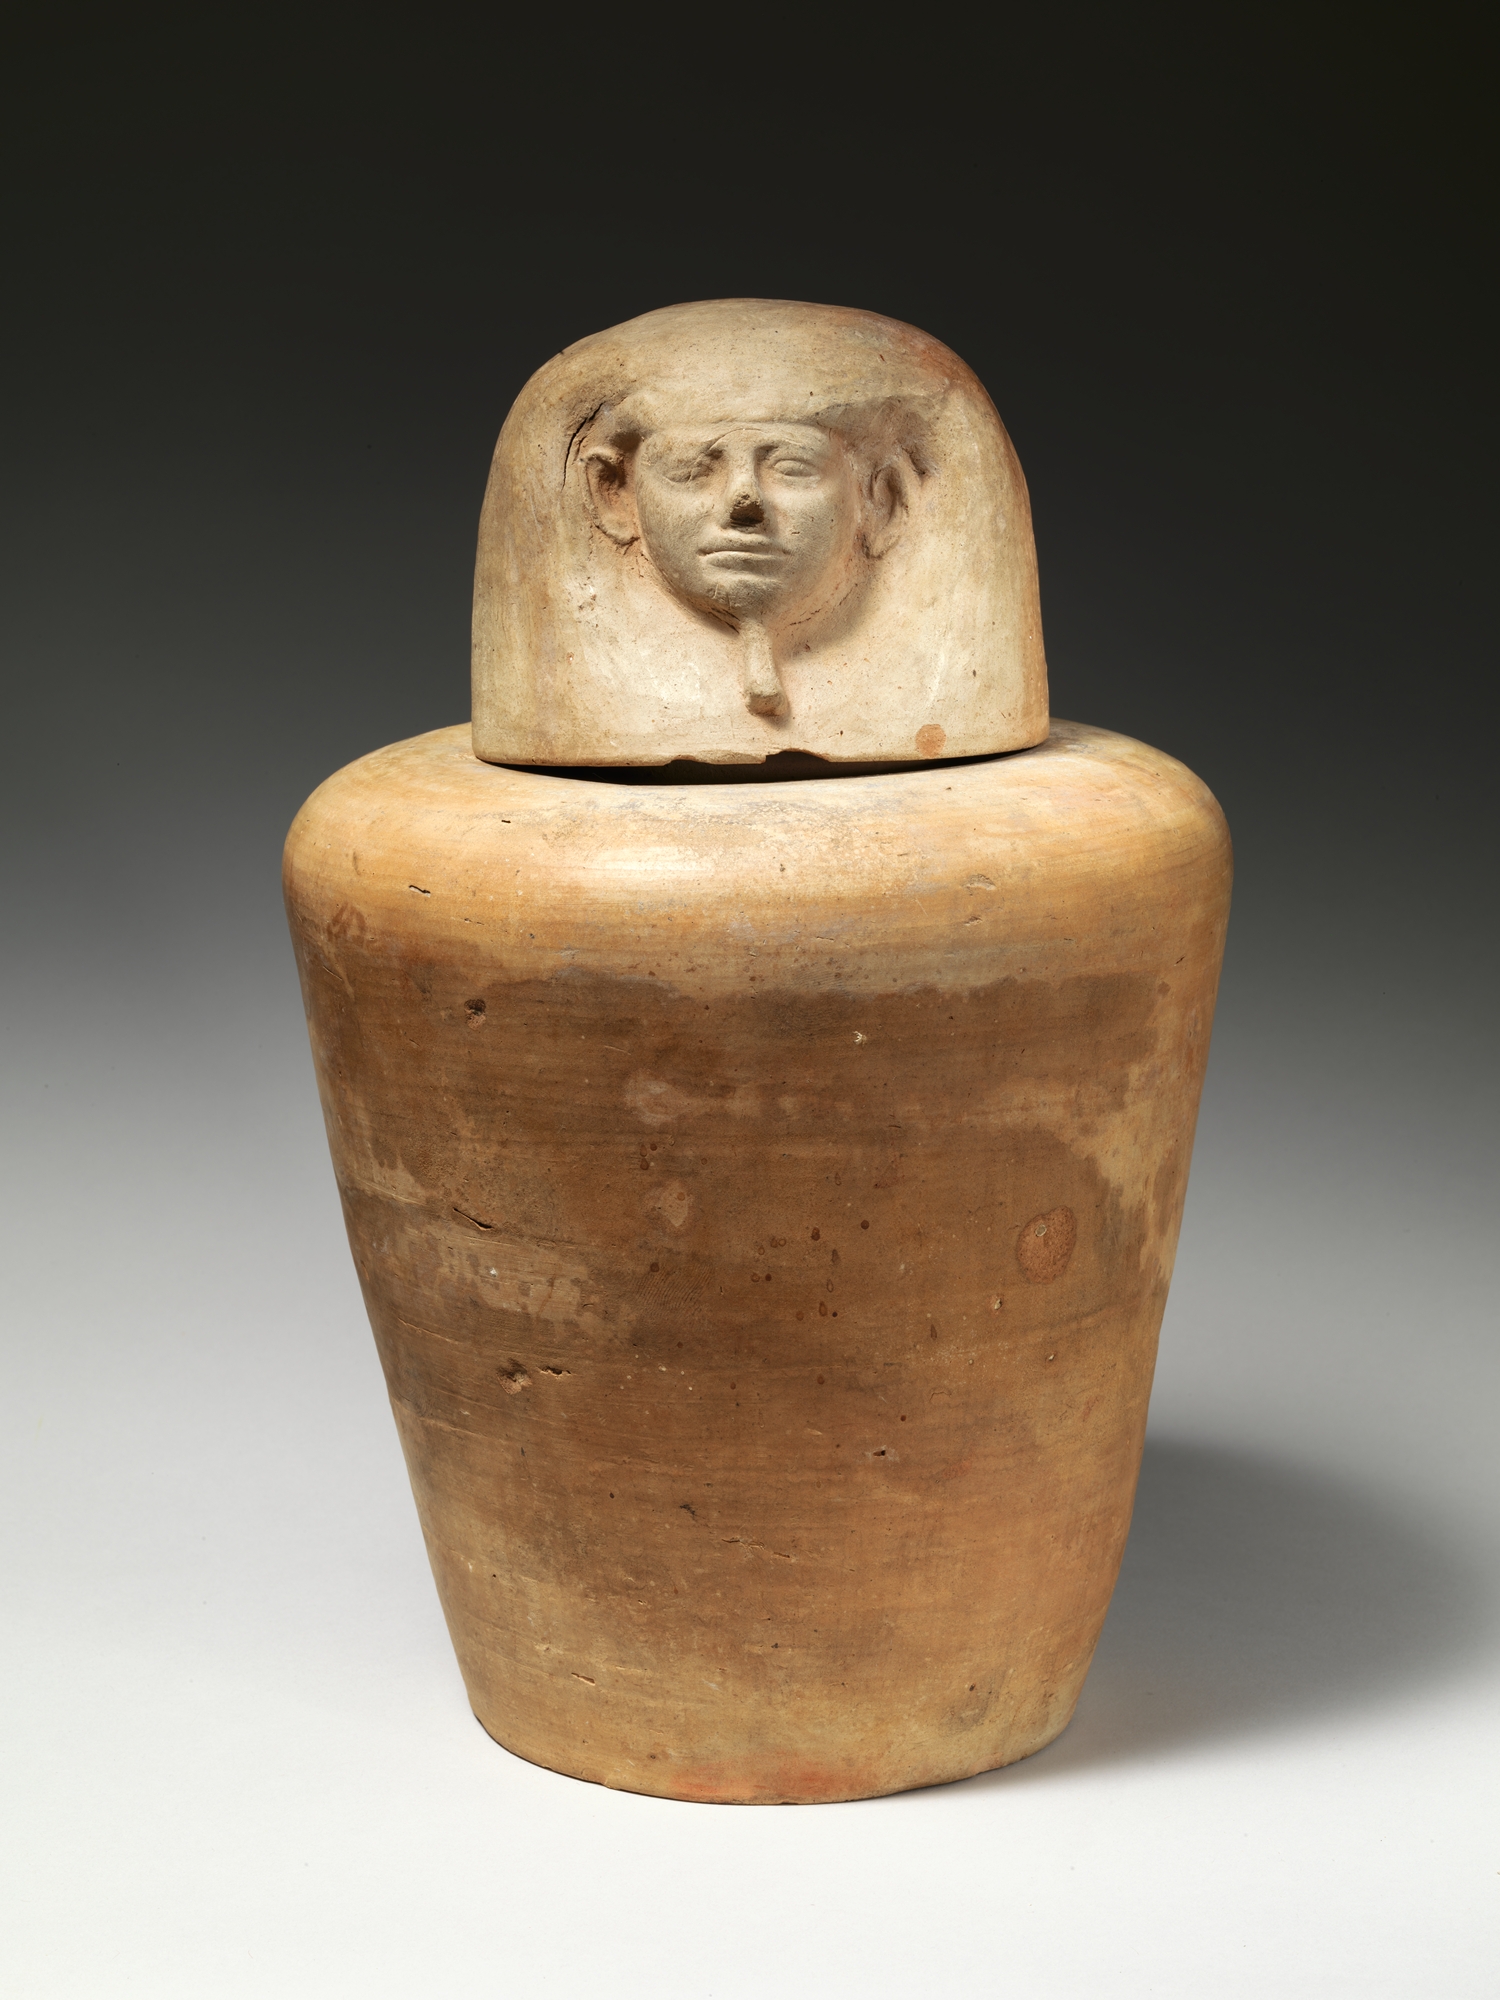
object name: canopic jar, human head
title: Canopic jar of Tetinakht: Imseti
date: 1550-1525 BCE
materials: pottery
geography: egypt